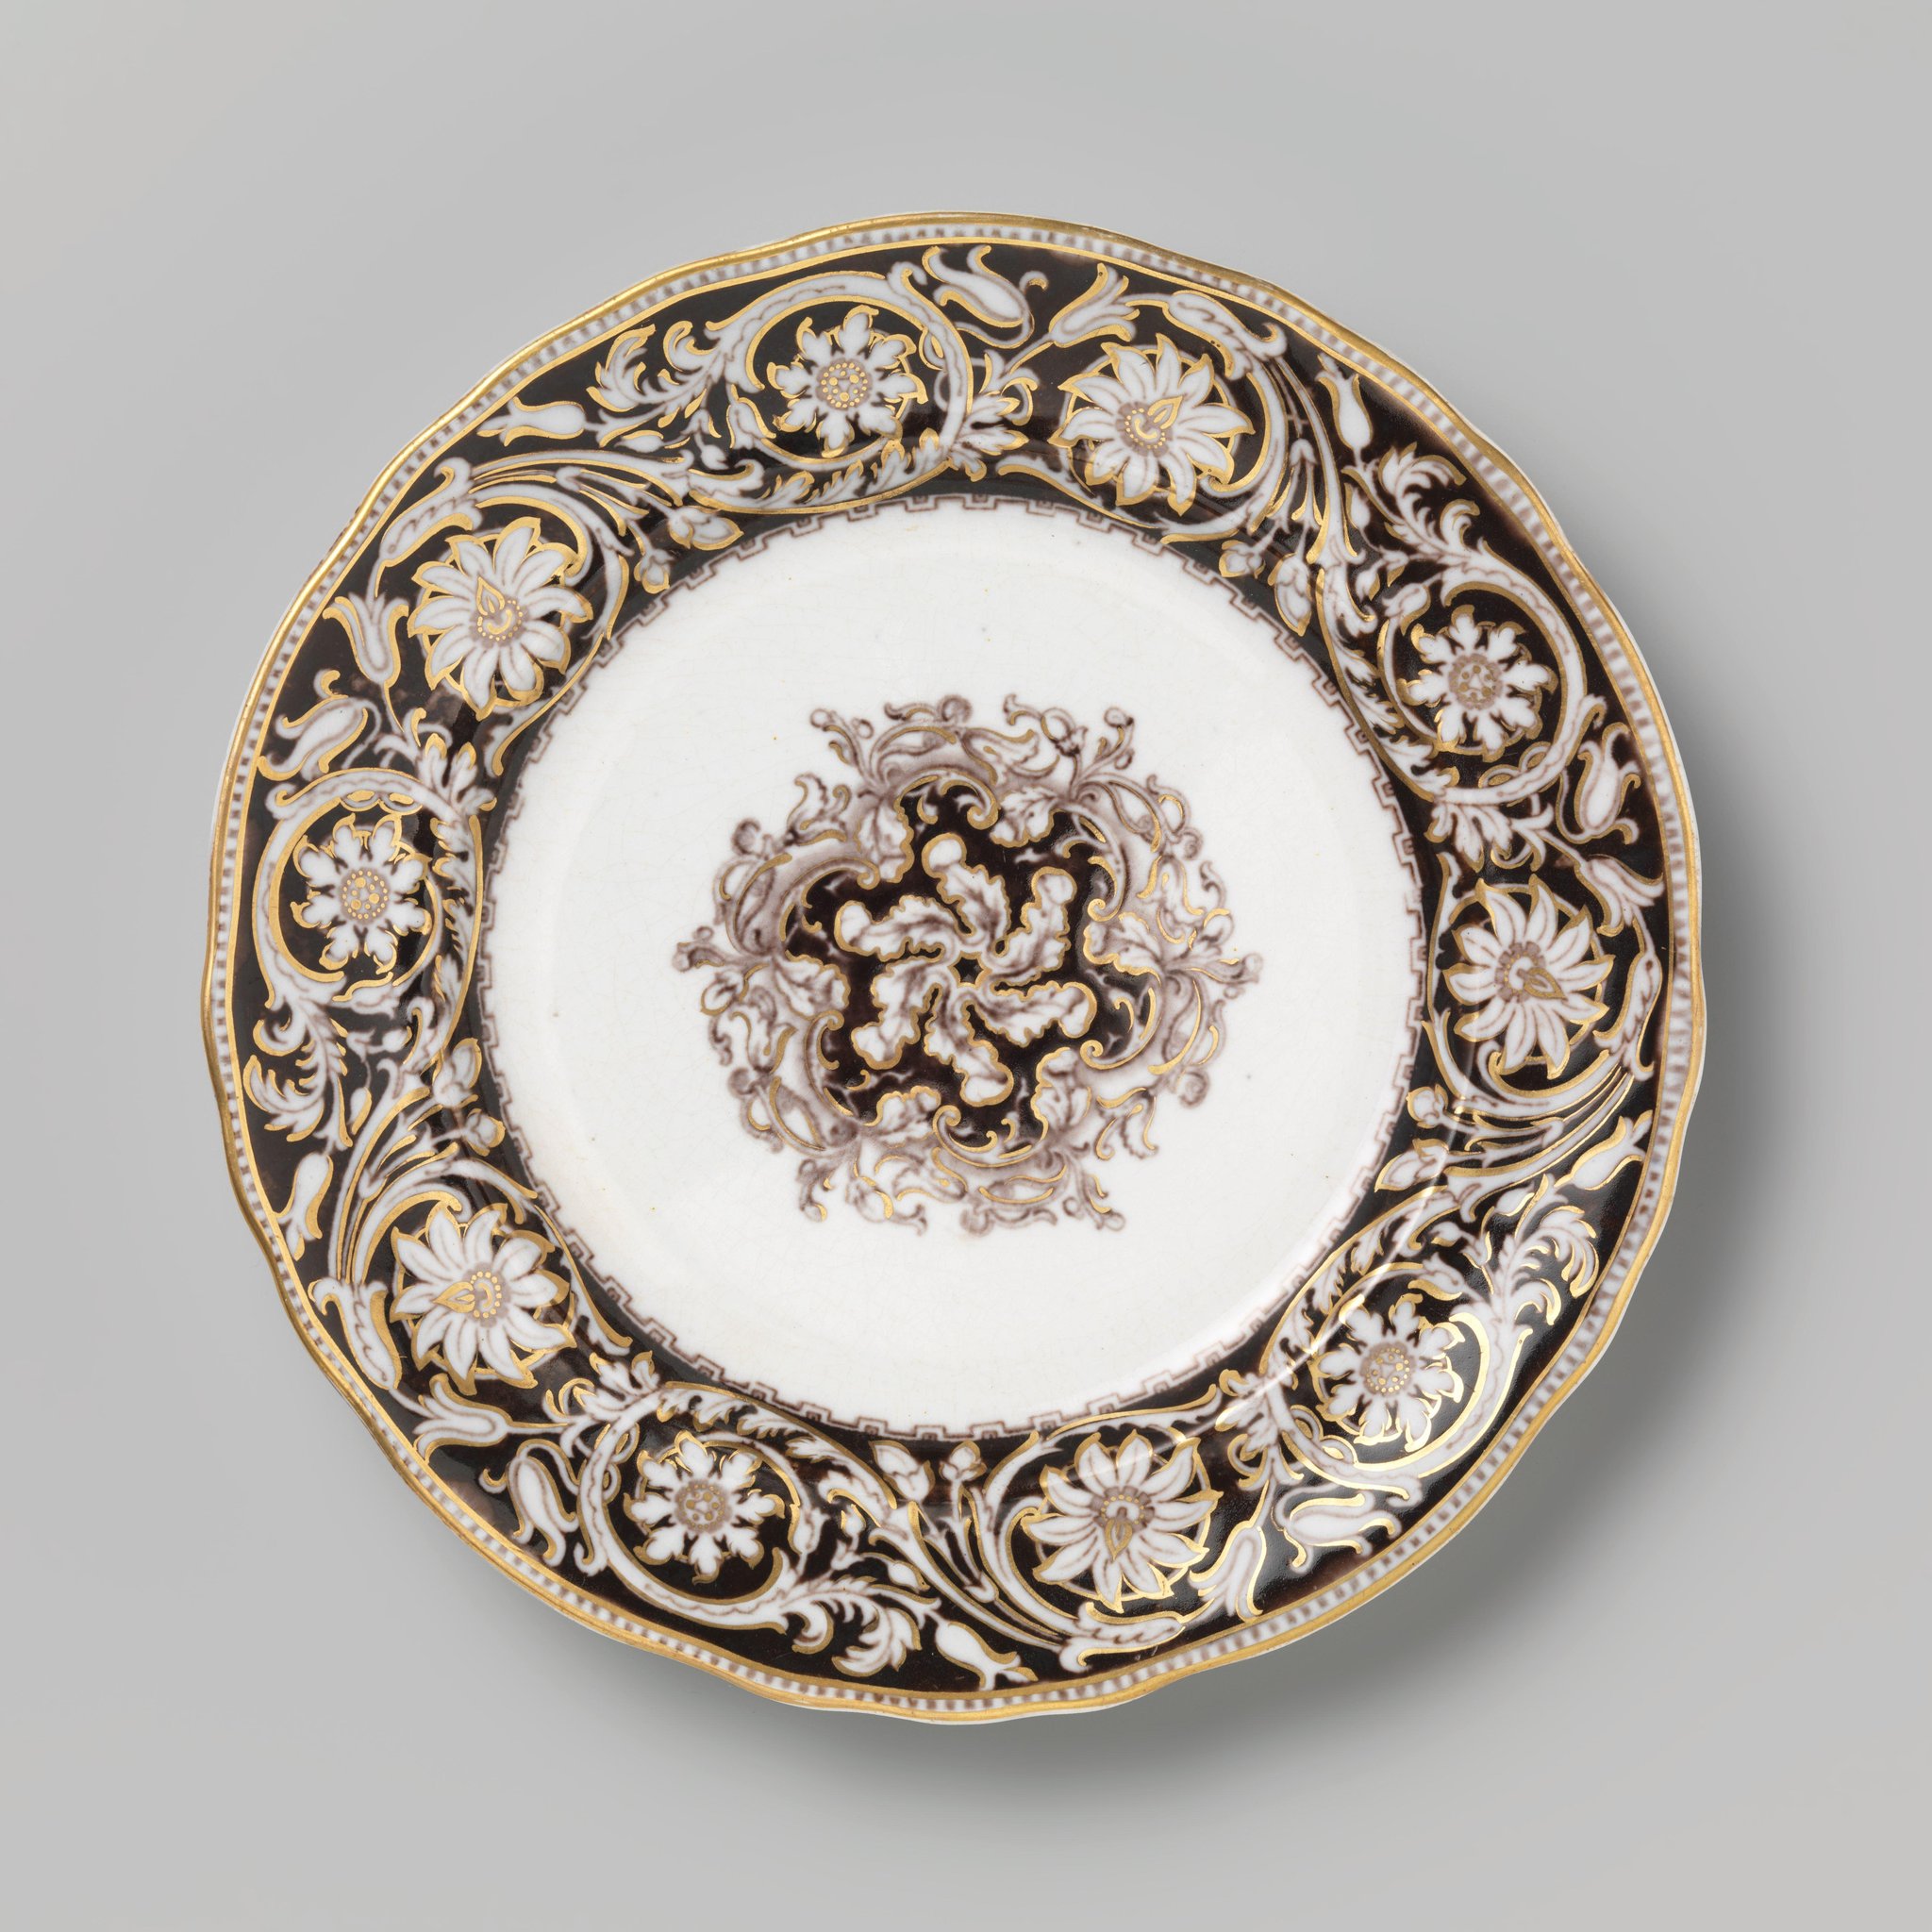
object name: plate dish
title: Bord van hardgebakken aardewerk met een paarse en goudkleurige decoraties.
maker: charles meigh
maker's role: aardewerkfabriek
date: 1840-1860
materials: earthenware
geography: hanley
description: Rond bord van hardgebakken aardewerk, met paars en goudkleurige decoraties. Het plat heeft in het midden een rozet en op de rand bloemenranken. Het bord is gemerkt: "improved Stone China".